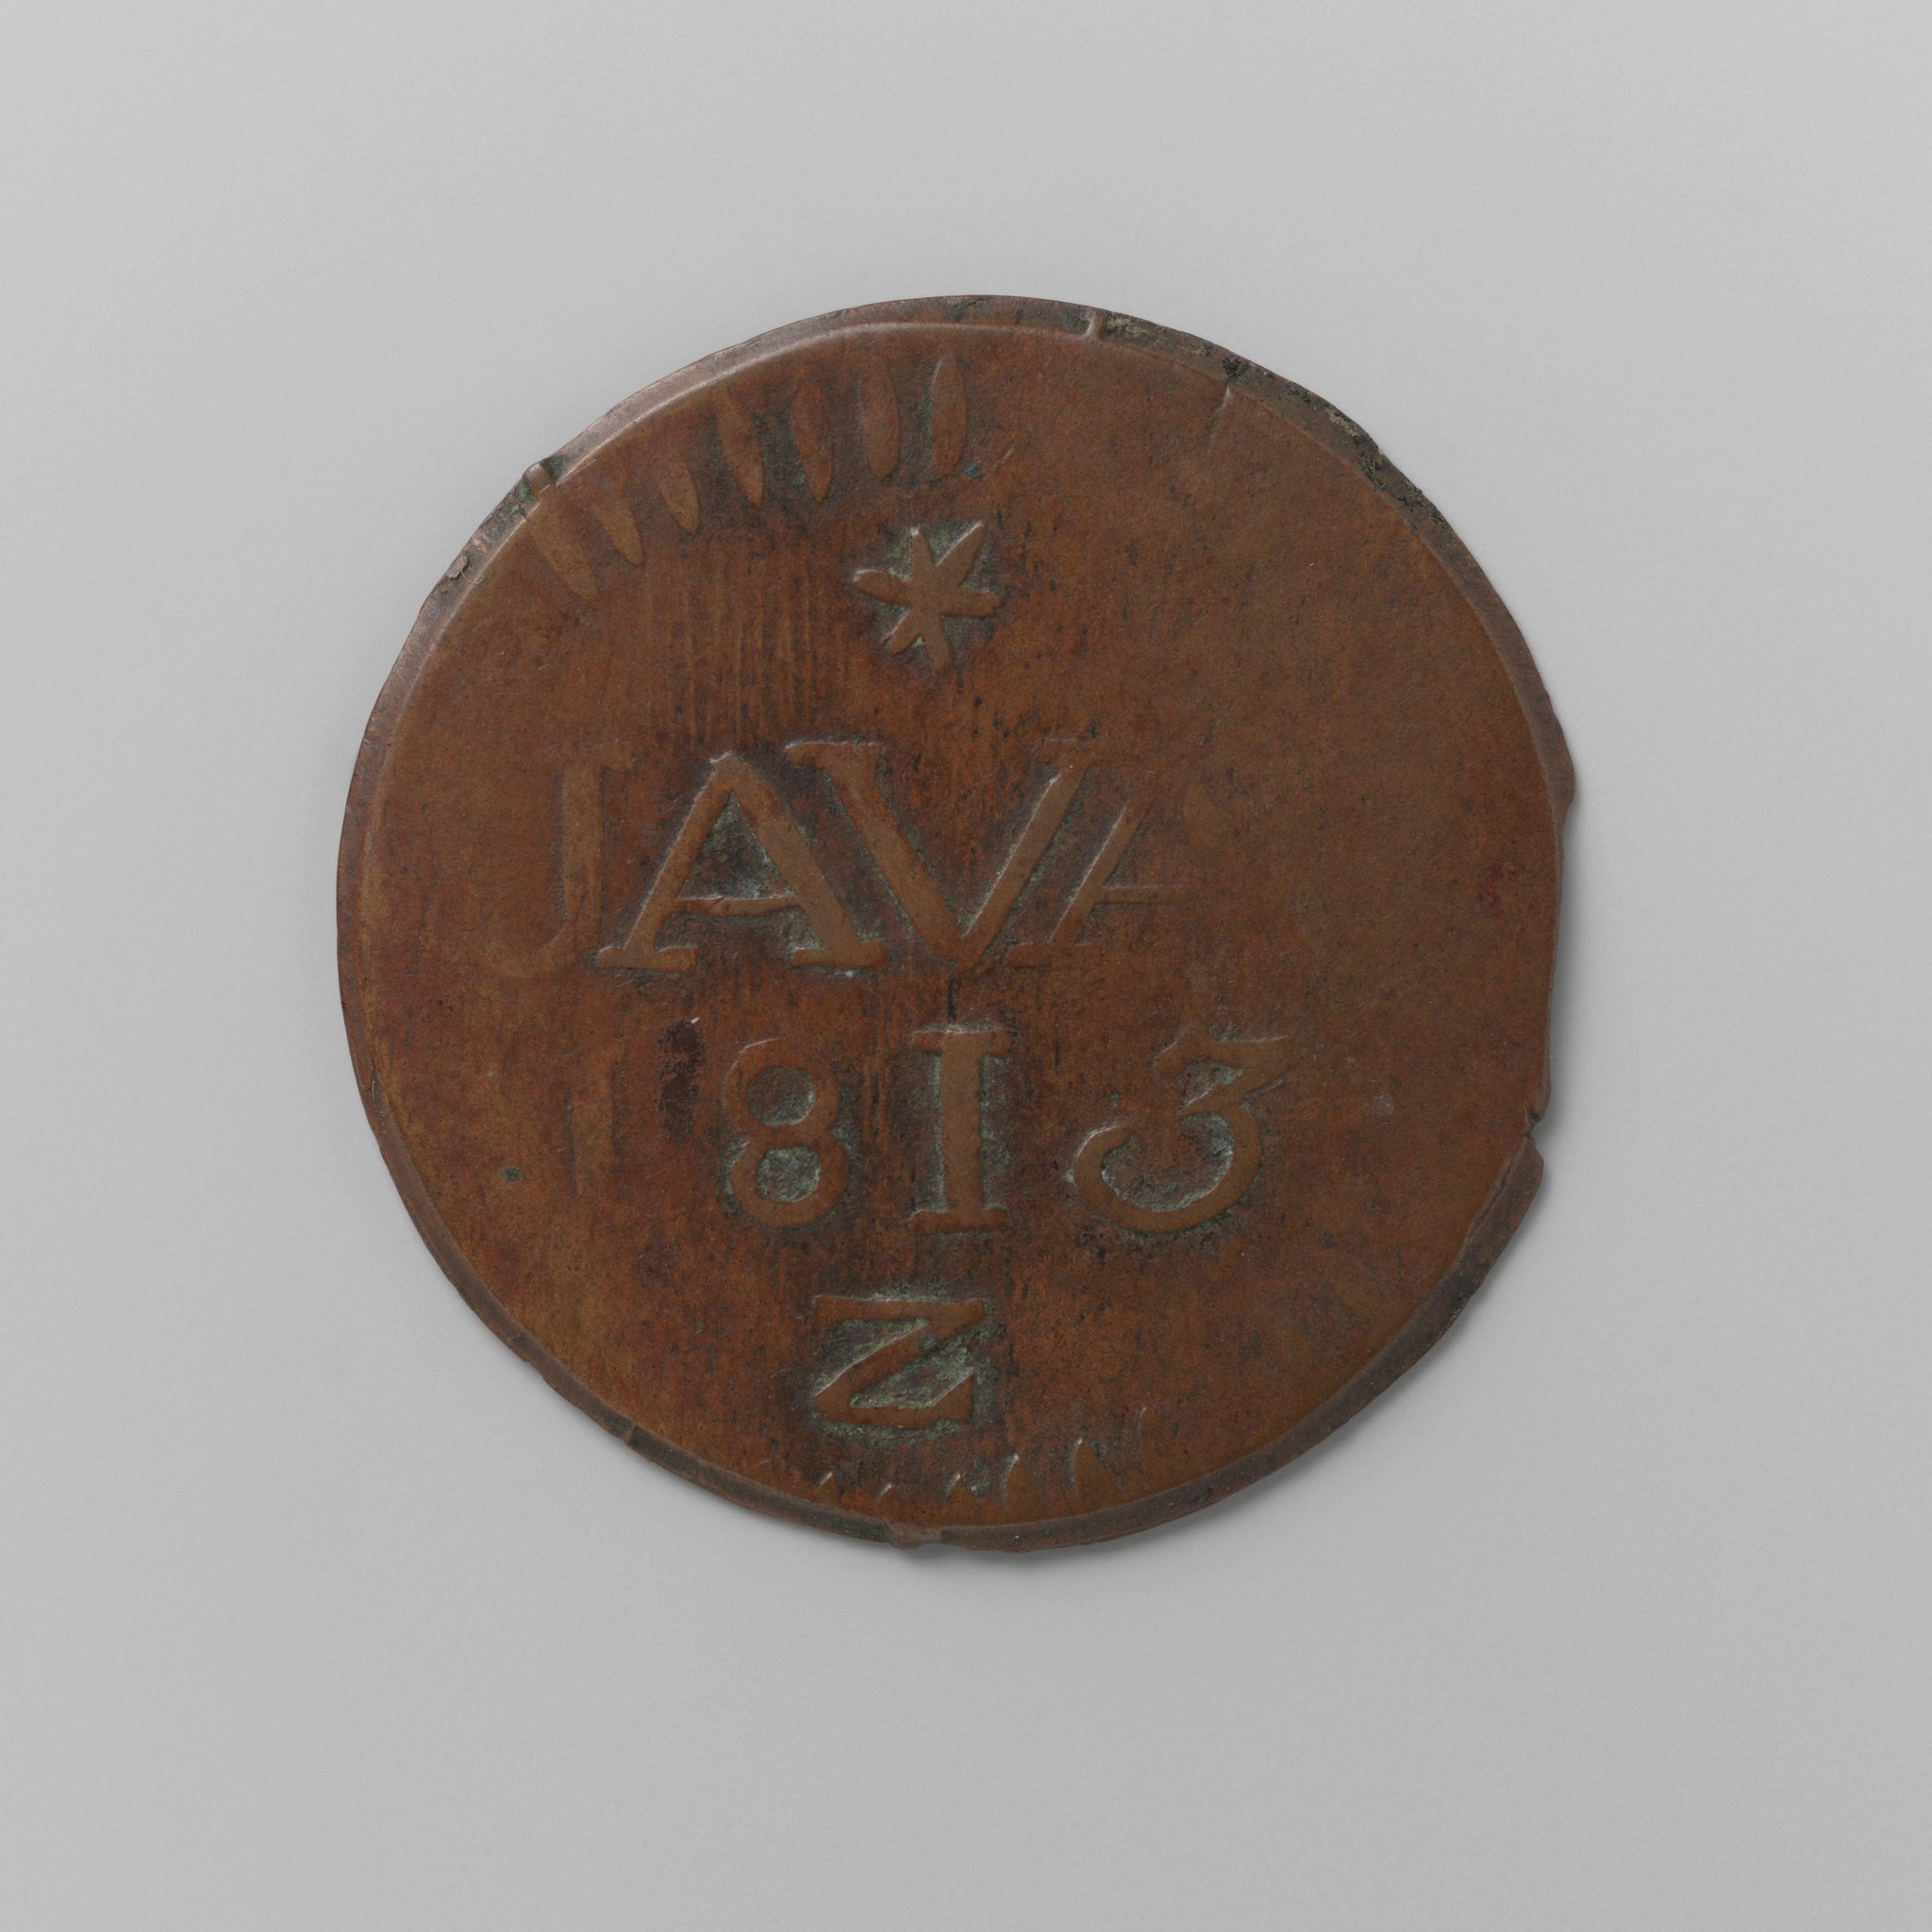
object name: coin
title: ½ stuiver voor Nederlands Indië tijdens Brits bestuur, 1813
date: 1813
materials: copper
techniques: striking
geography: surabaya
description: Koperen munt. Voorzijde: tussen waarde-aanduiding ½ St monogram van de Engelse Oostindische Compagnie. Daarboven letter B [=British]. Keerzijde: eenregelig opschrift, waaronder jaartal. Boven opschrift muntteken en onder jaartal muntmeesterteken Z [=muntmeester Zwekkert].